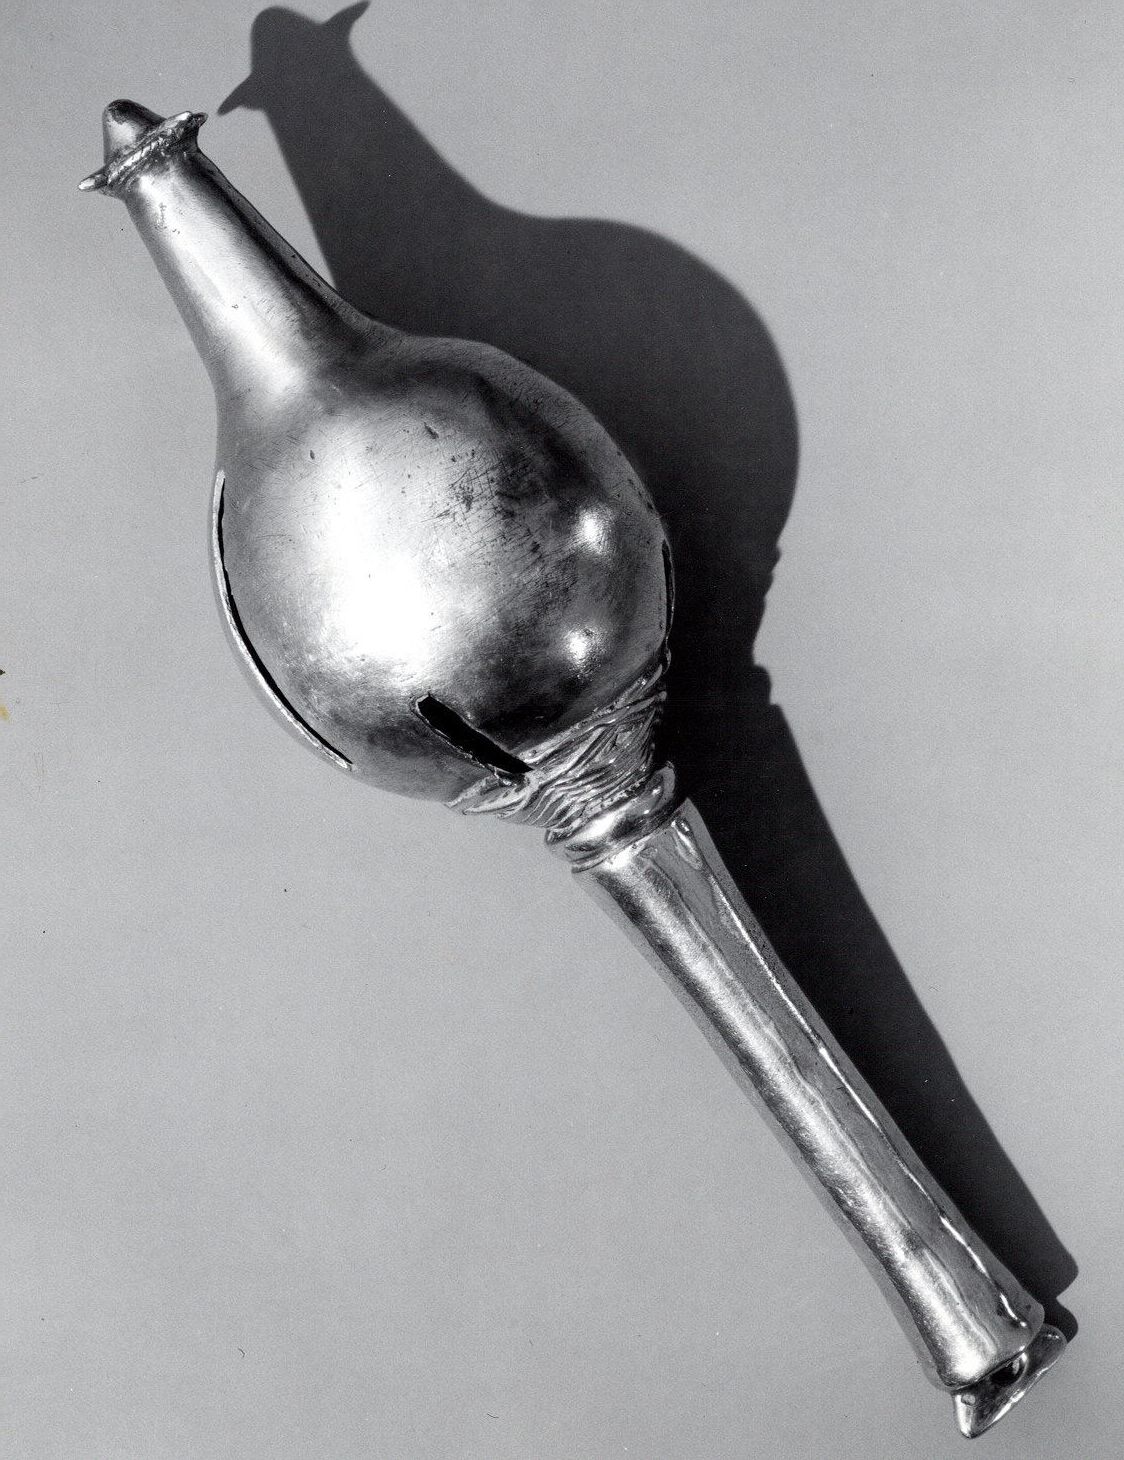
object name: rattle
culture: early quimbaya or zenú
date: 300 BCE-1000 CE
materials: alloy, gold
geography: colombia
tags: musical instruments